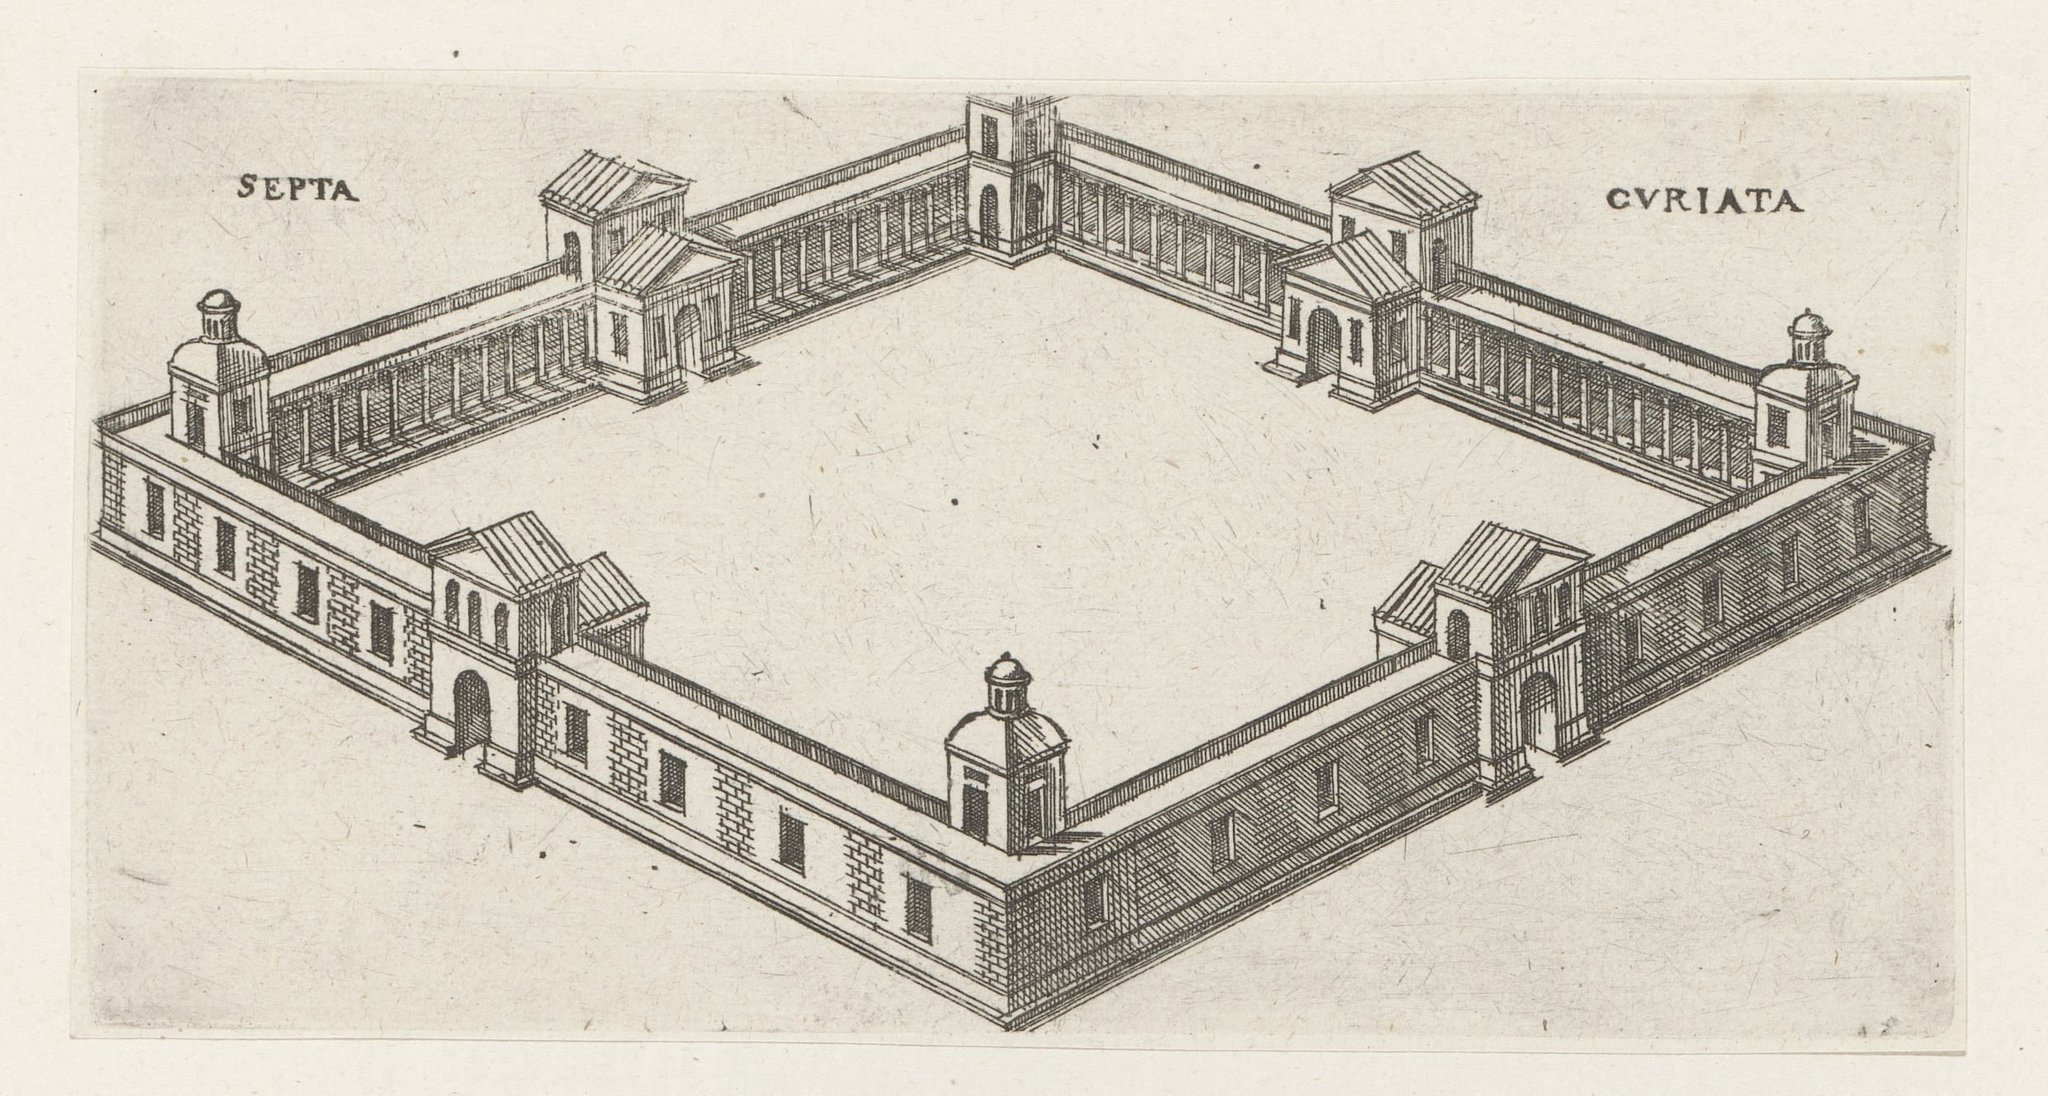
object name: album leaf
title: Livre des edifices antiques romains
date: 1584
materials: paper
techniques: etching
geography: france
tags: representation of real building (either existing or having existed), rome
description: Deze prent maakt deel uit van een serie van 98 prenten gedrukt op 48 bladen. De bladen zijn verknipt en een selectie van de losse prenten is in dit album geplakt.